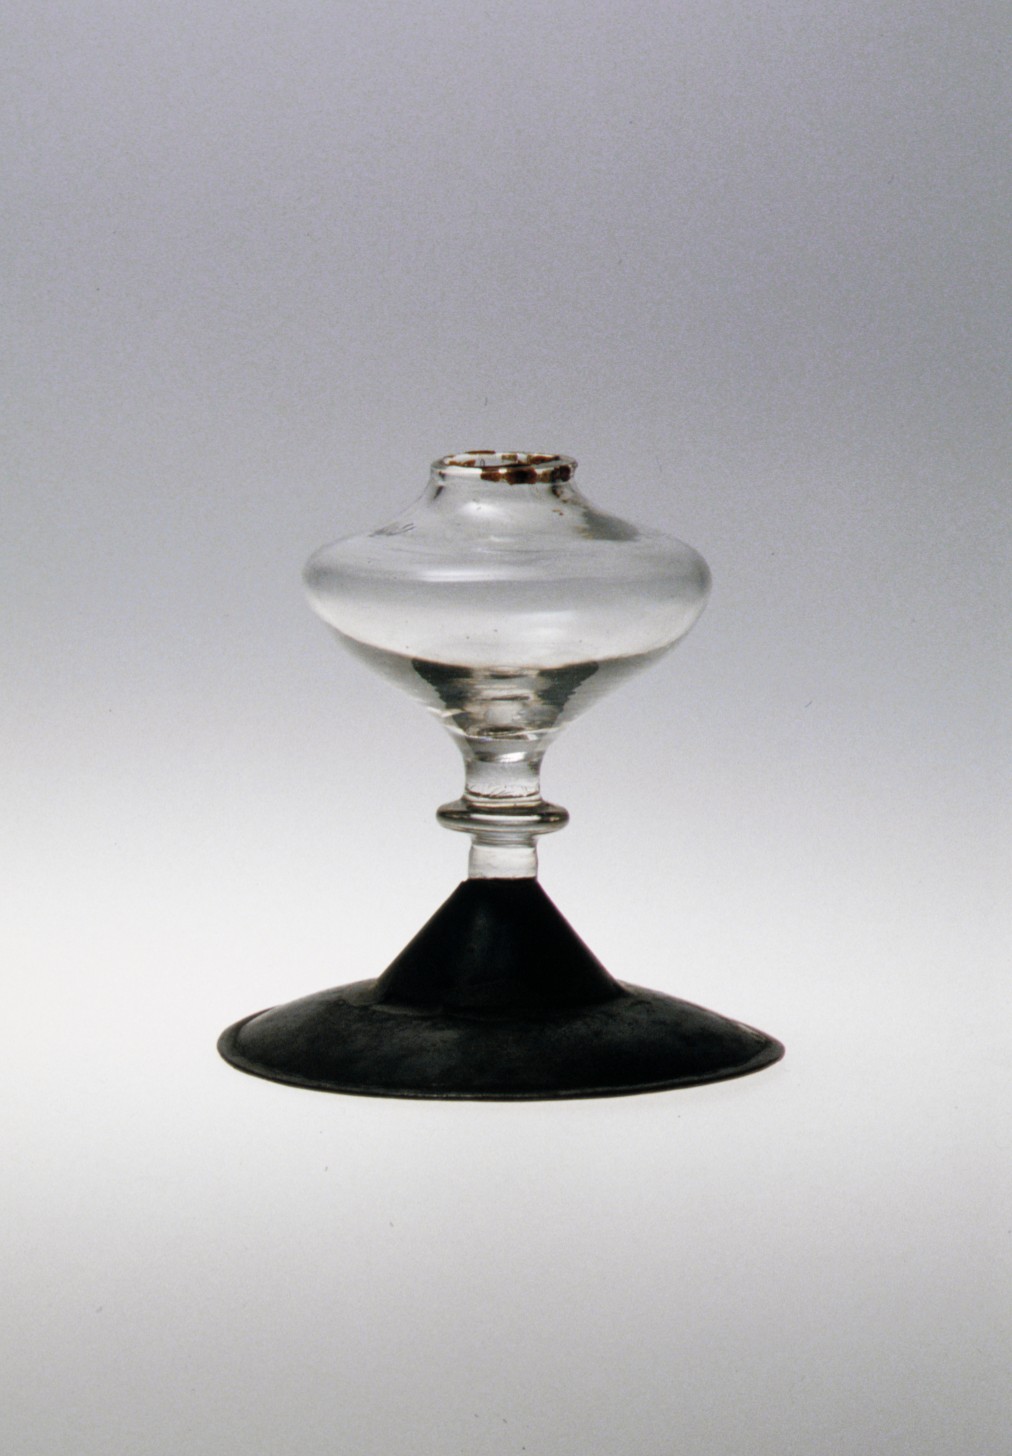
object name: whale oil lamp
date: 1825-1845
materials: glass, lead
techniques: glassblowing, pressed